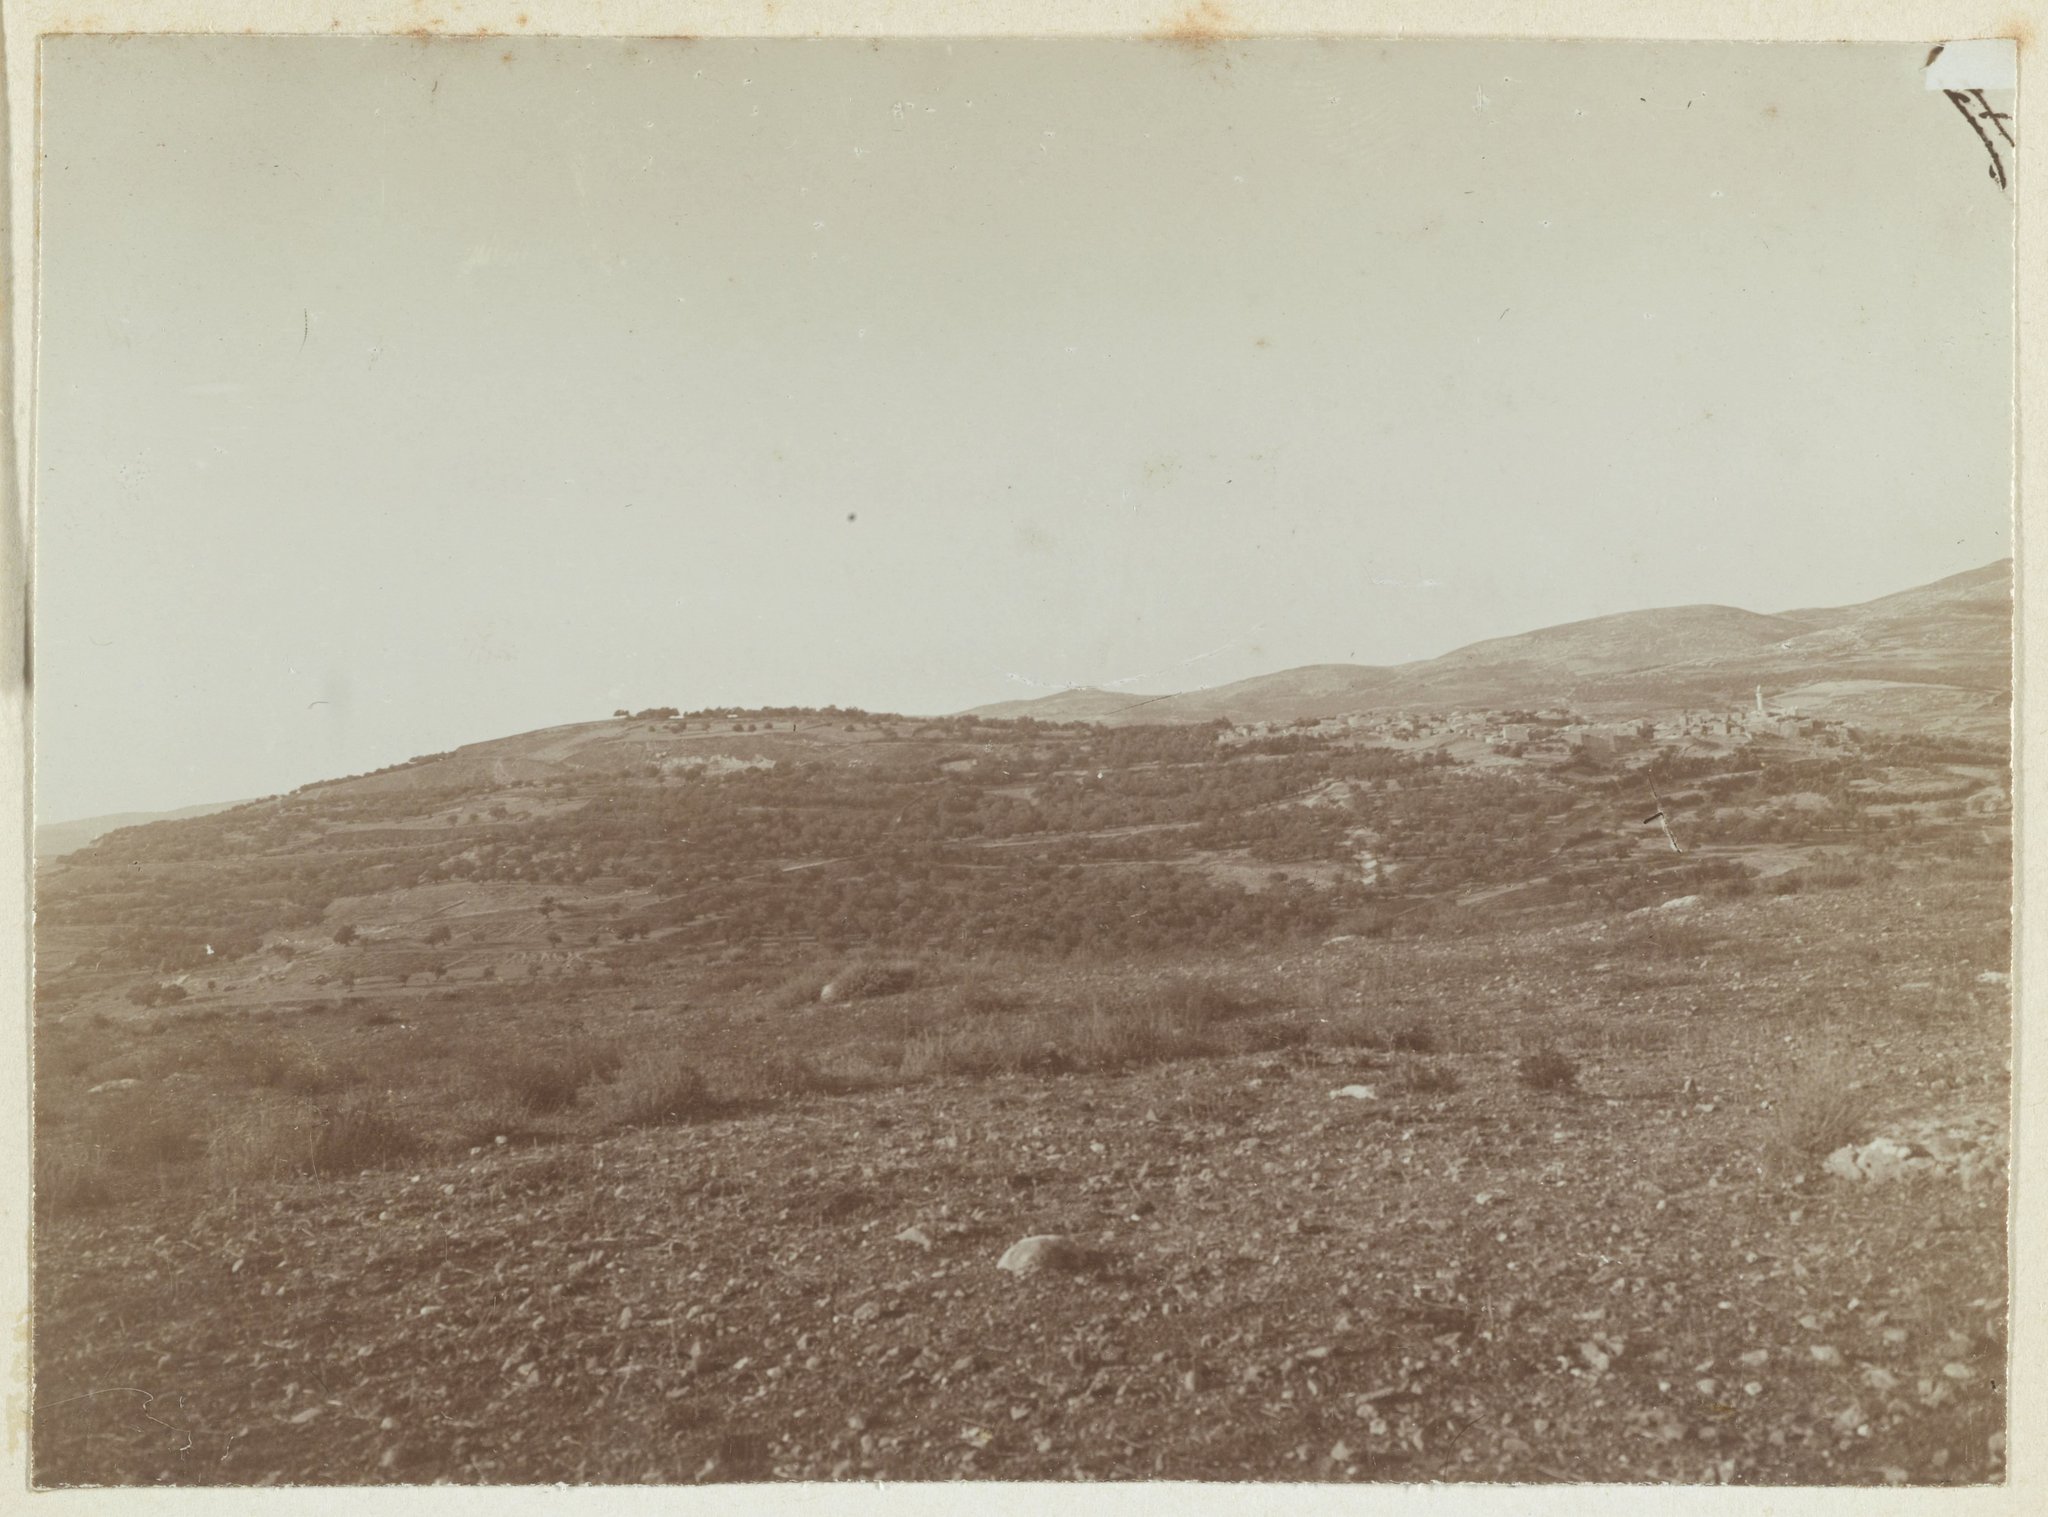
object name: photograph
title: Gezicht op Samaria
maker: johannes lodewijk heldring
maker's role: fotograaf, predikant, schrijver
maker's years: 1852-1923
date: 1898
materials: paper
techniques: collodion silver print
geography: israel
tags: city-view in general; 'veduta'